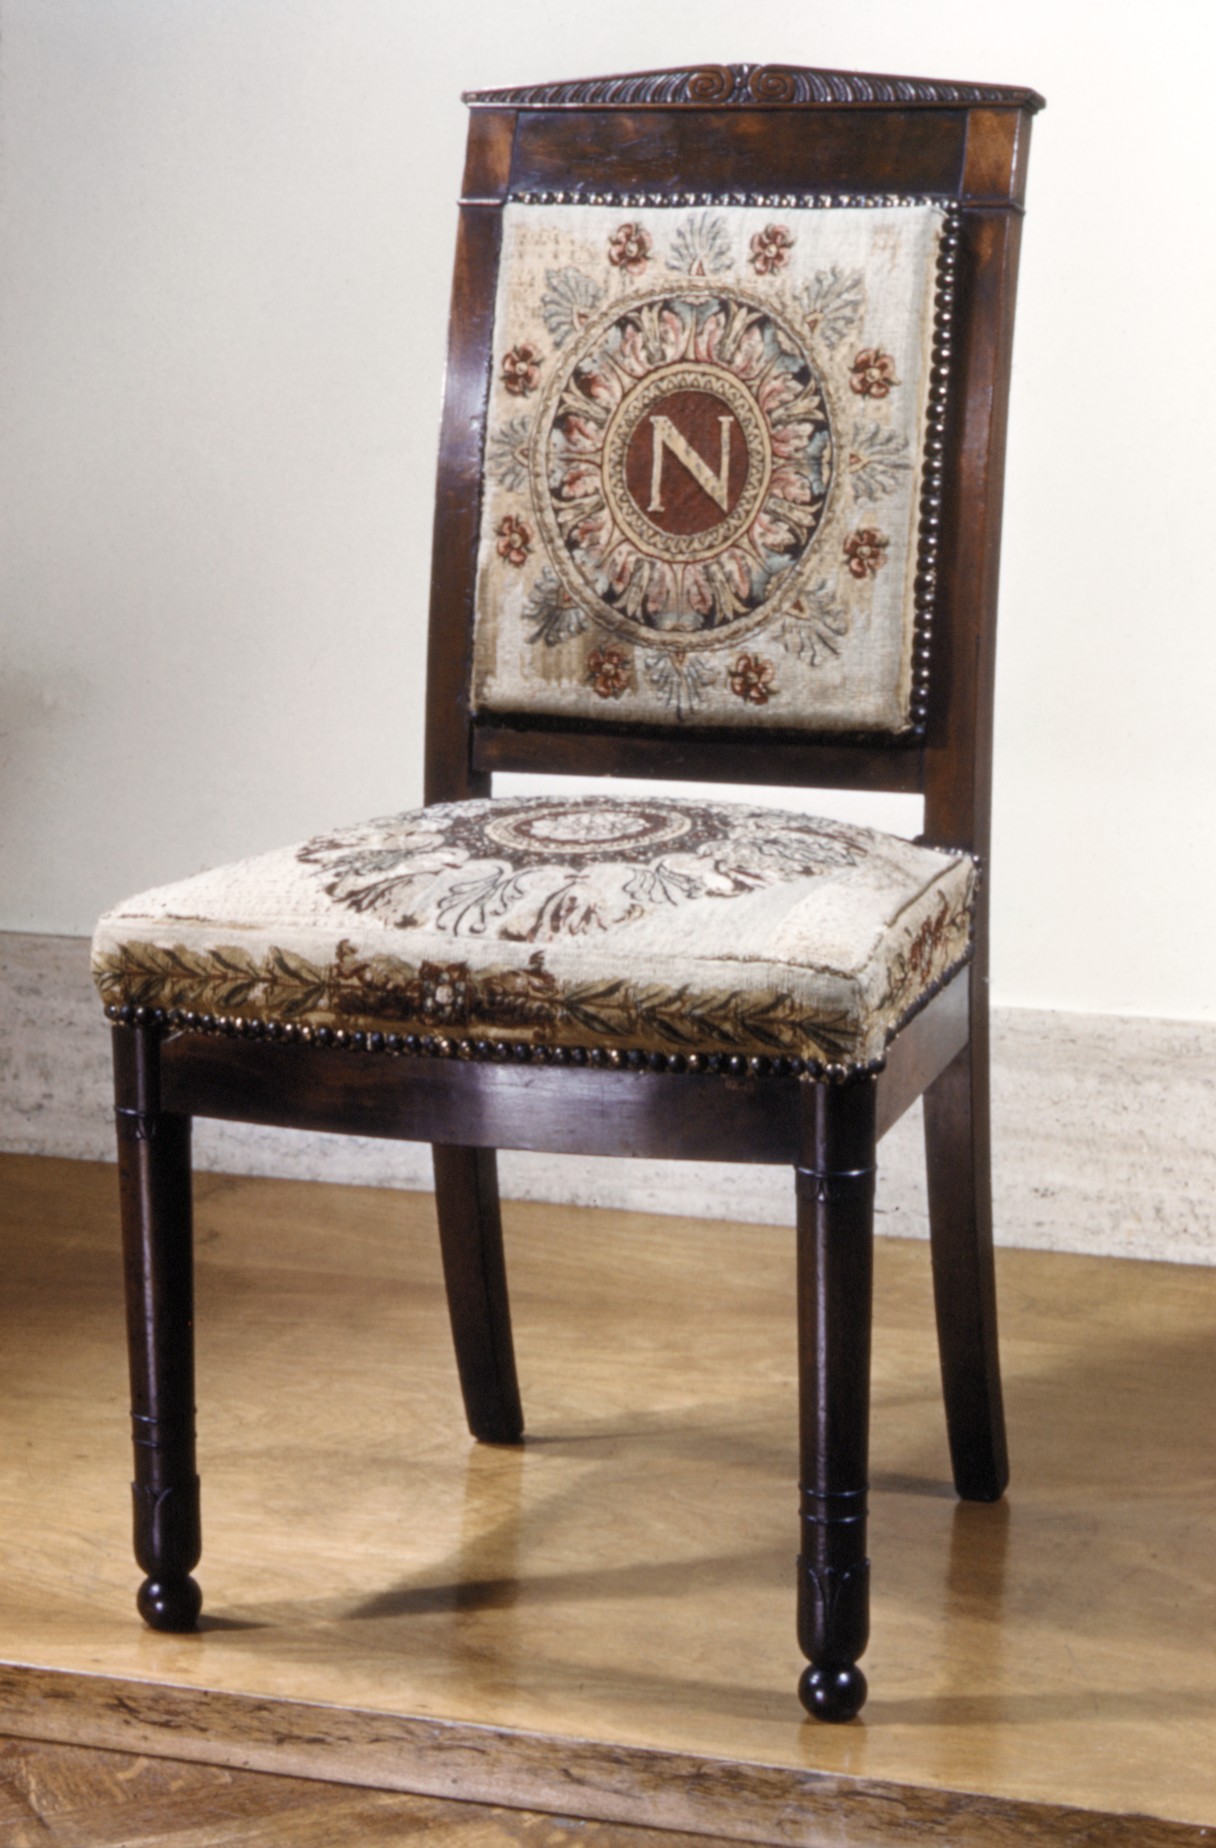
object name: chair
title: Chair (one of a pair)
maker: beauvais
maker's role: factory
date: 1801-1833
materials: wood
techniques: tapestry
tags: flowers,insignia